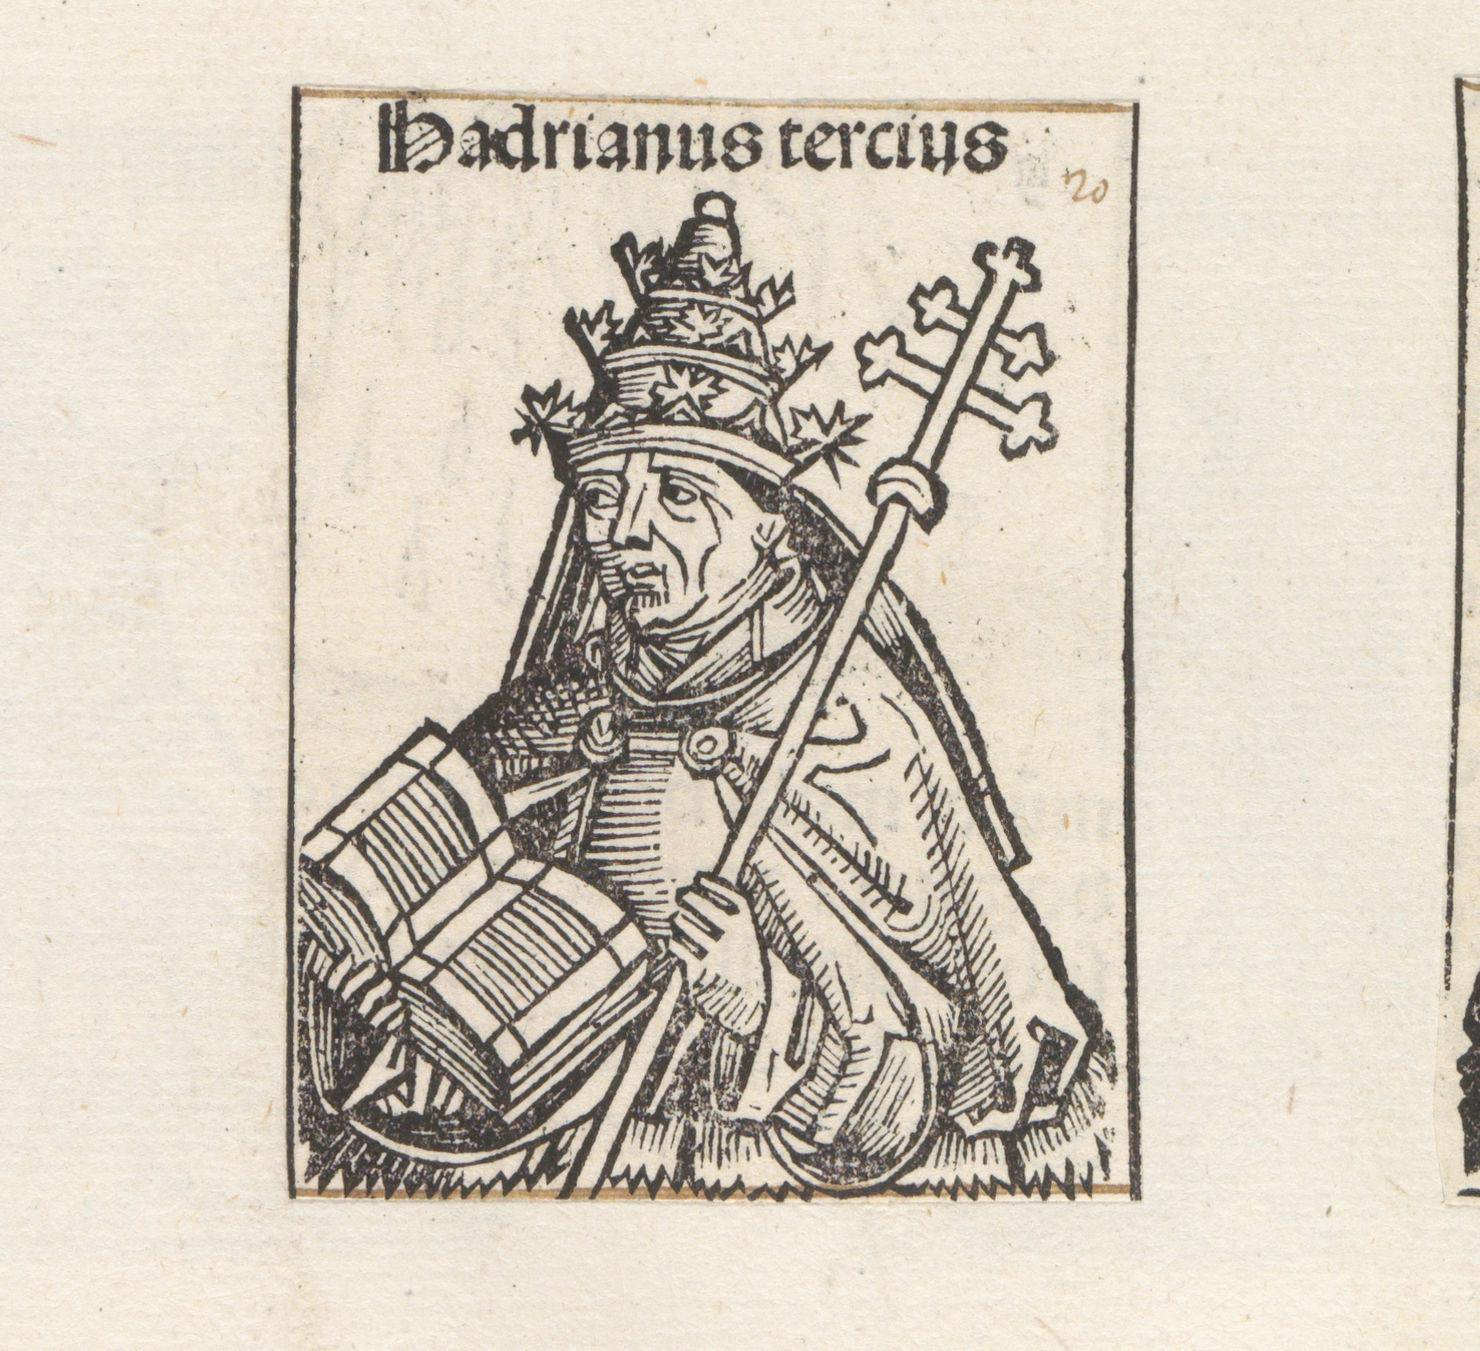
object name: album leaf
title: Hadrianus tercius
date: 1493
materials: paper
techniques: letterpress printing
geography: nuremberg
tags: pope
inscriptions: inscription: ‘20’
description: Een bloemkelk met een paus. Hij draagt een tiara en heeft een opengeslagen bijbel en een staf met een dubbel kruis in zijn handen. De voorstelling is onderdeel van de opeenvolging pausen in de Liber Chronicarum. De tekst identificeert de man als paus Adrianus III. De prent maakt deel uit van een album.